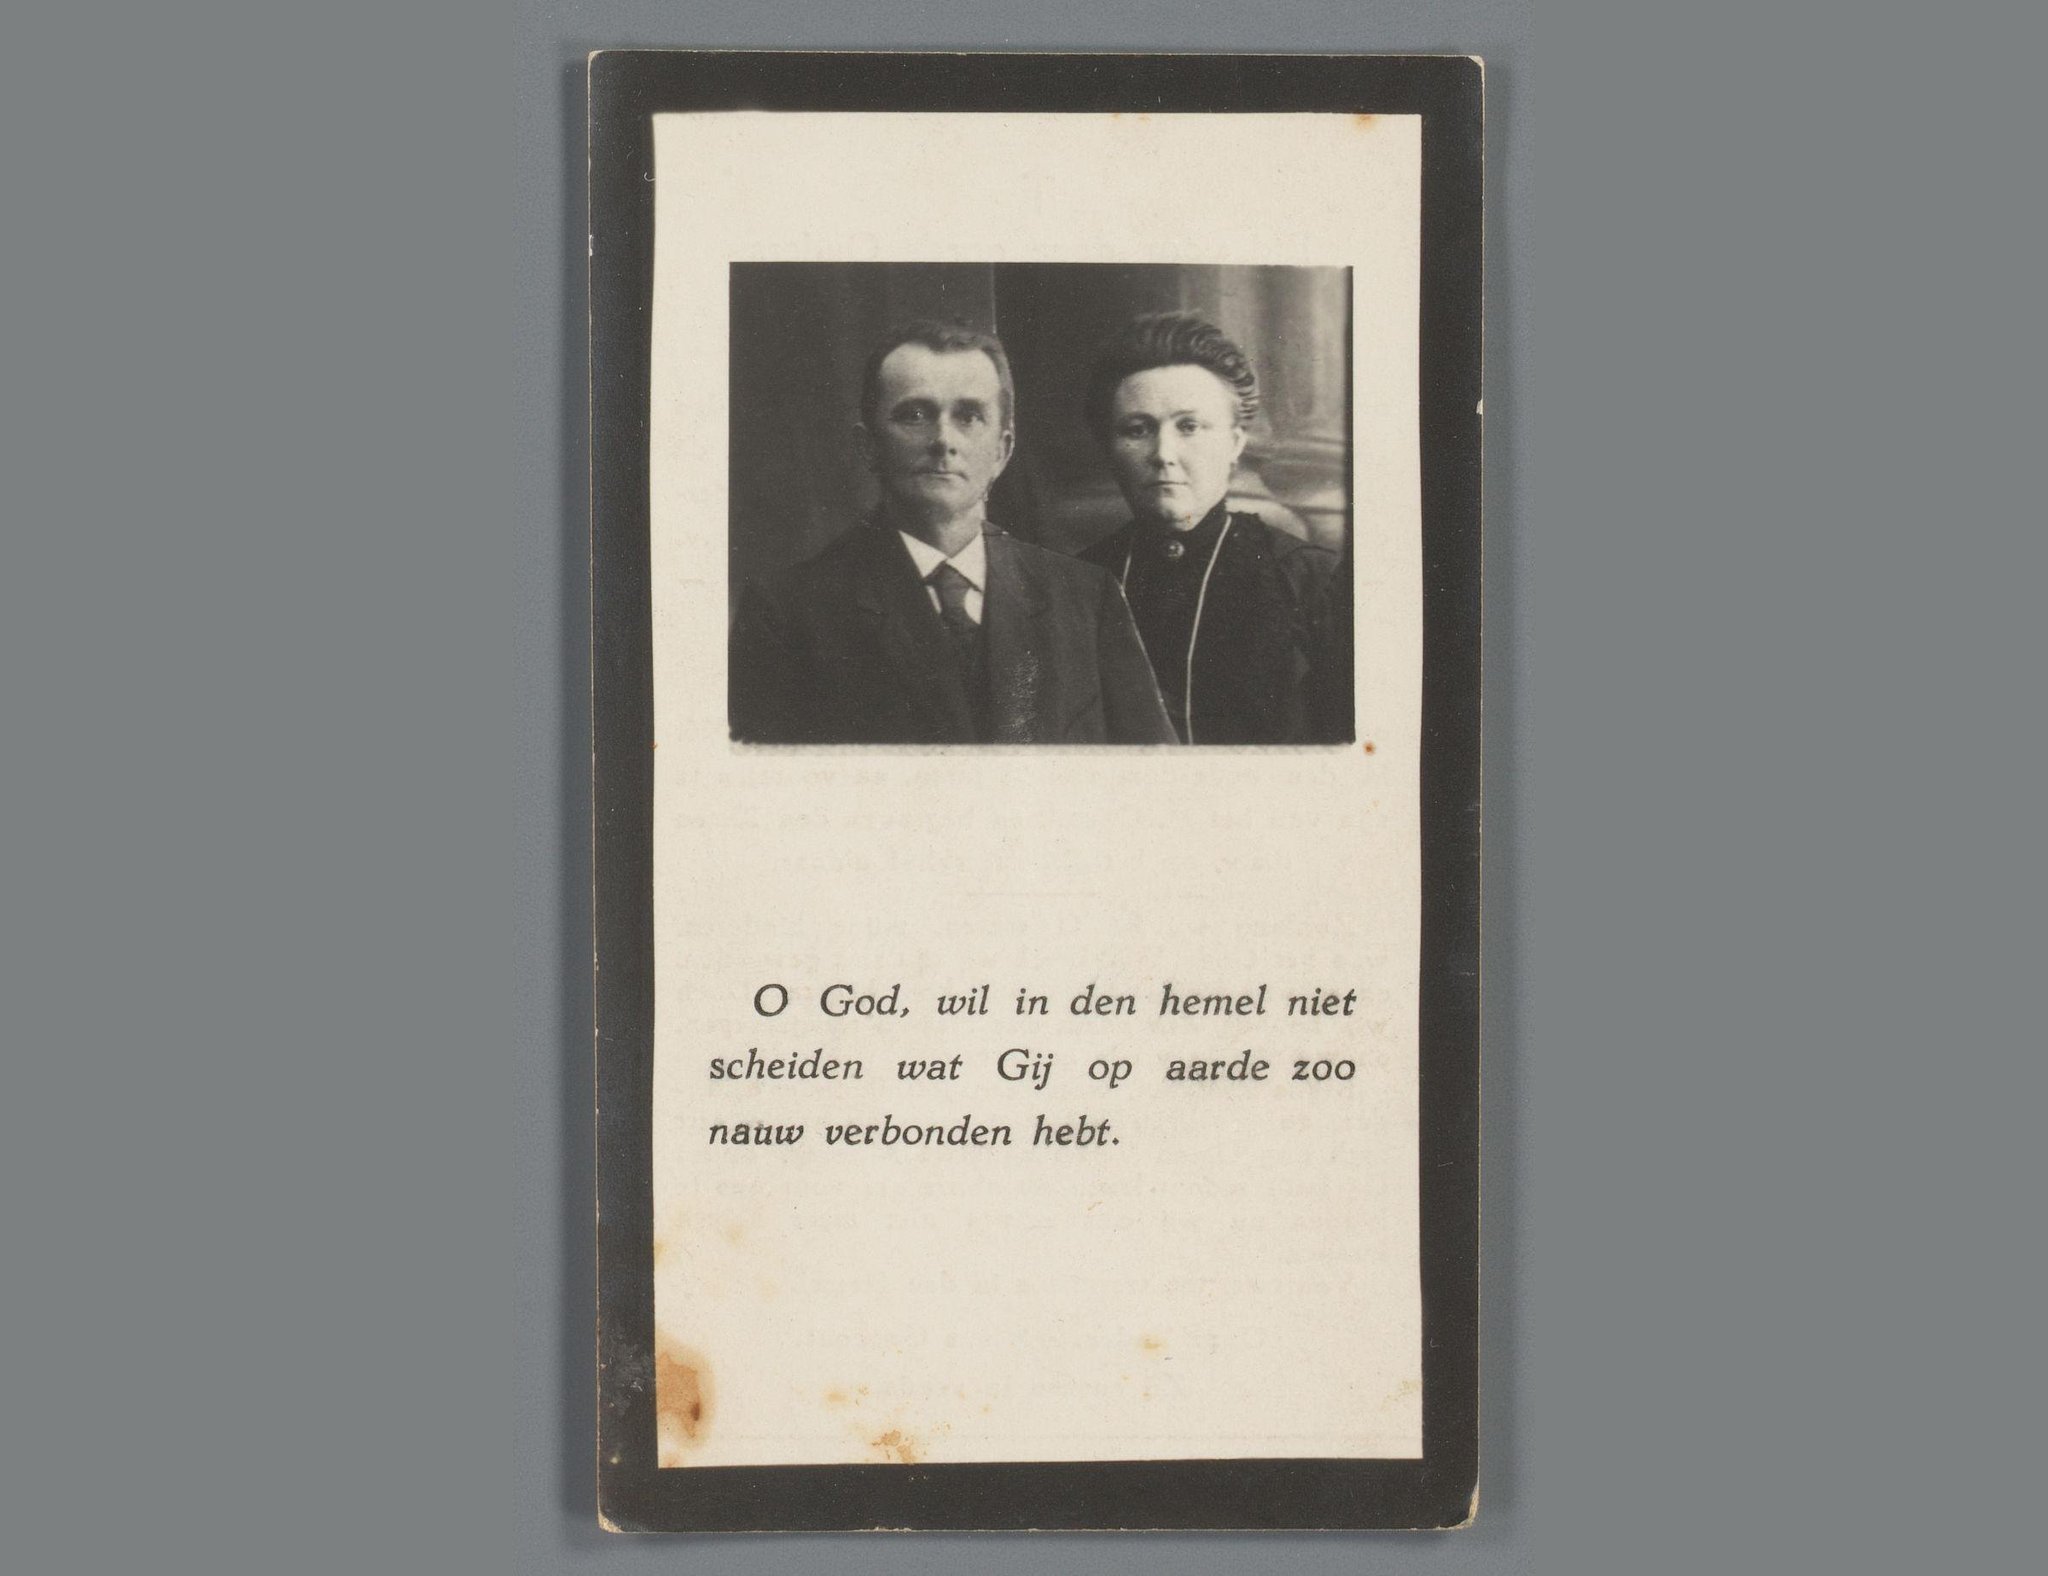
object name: prayer card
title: Portret van P. van Wijngaarden en zijn echtgenote Cornelia Maria Kruik op bidprent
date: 1927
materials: paper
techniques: gelatin silver print, letterpress printing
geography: poeldijk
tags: historical persons, couple of lovers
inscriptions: inscription: ‘Bid voor onze goede Ouders (...) Zij rusten in vrede./ S.C. Kruijk - Poeldijk.’